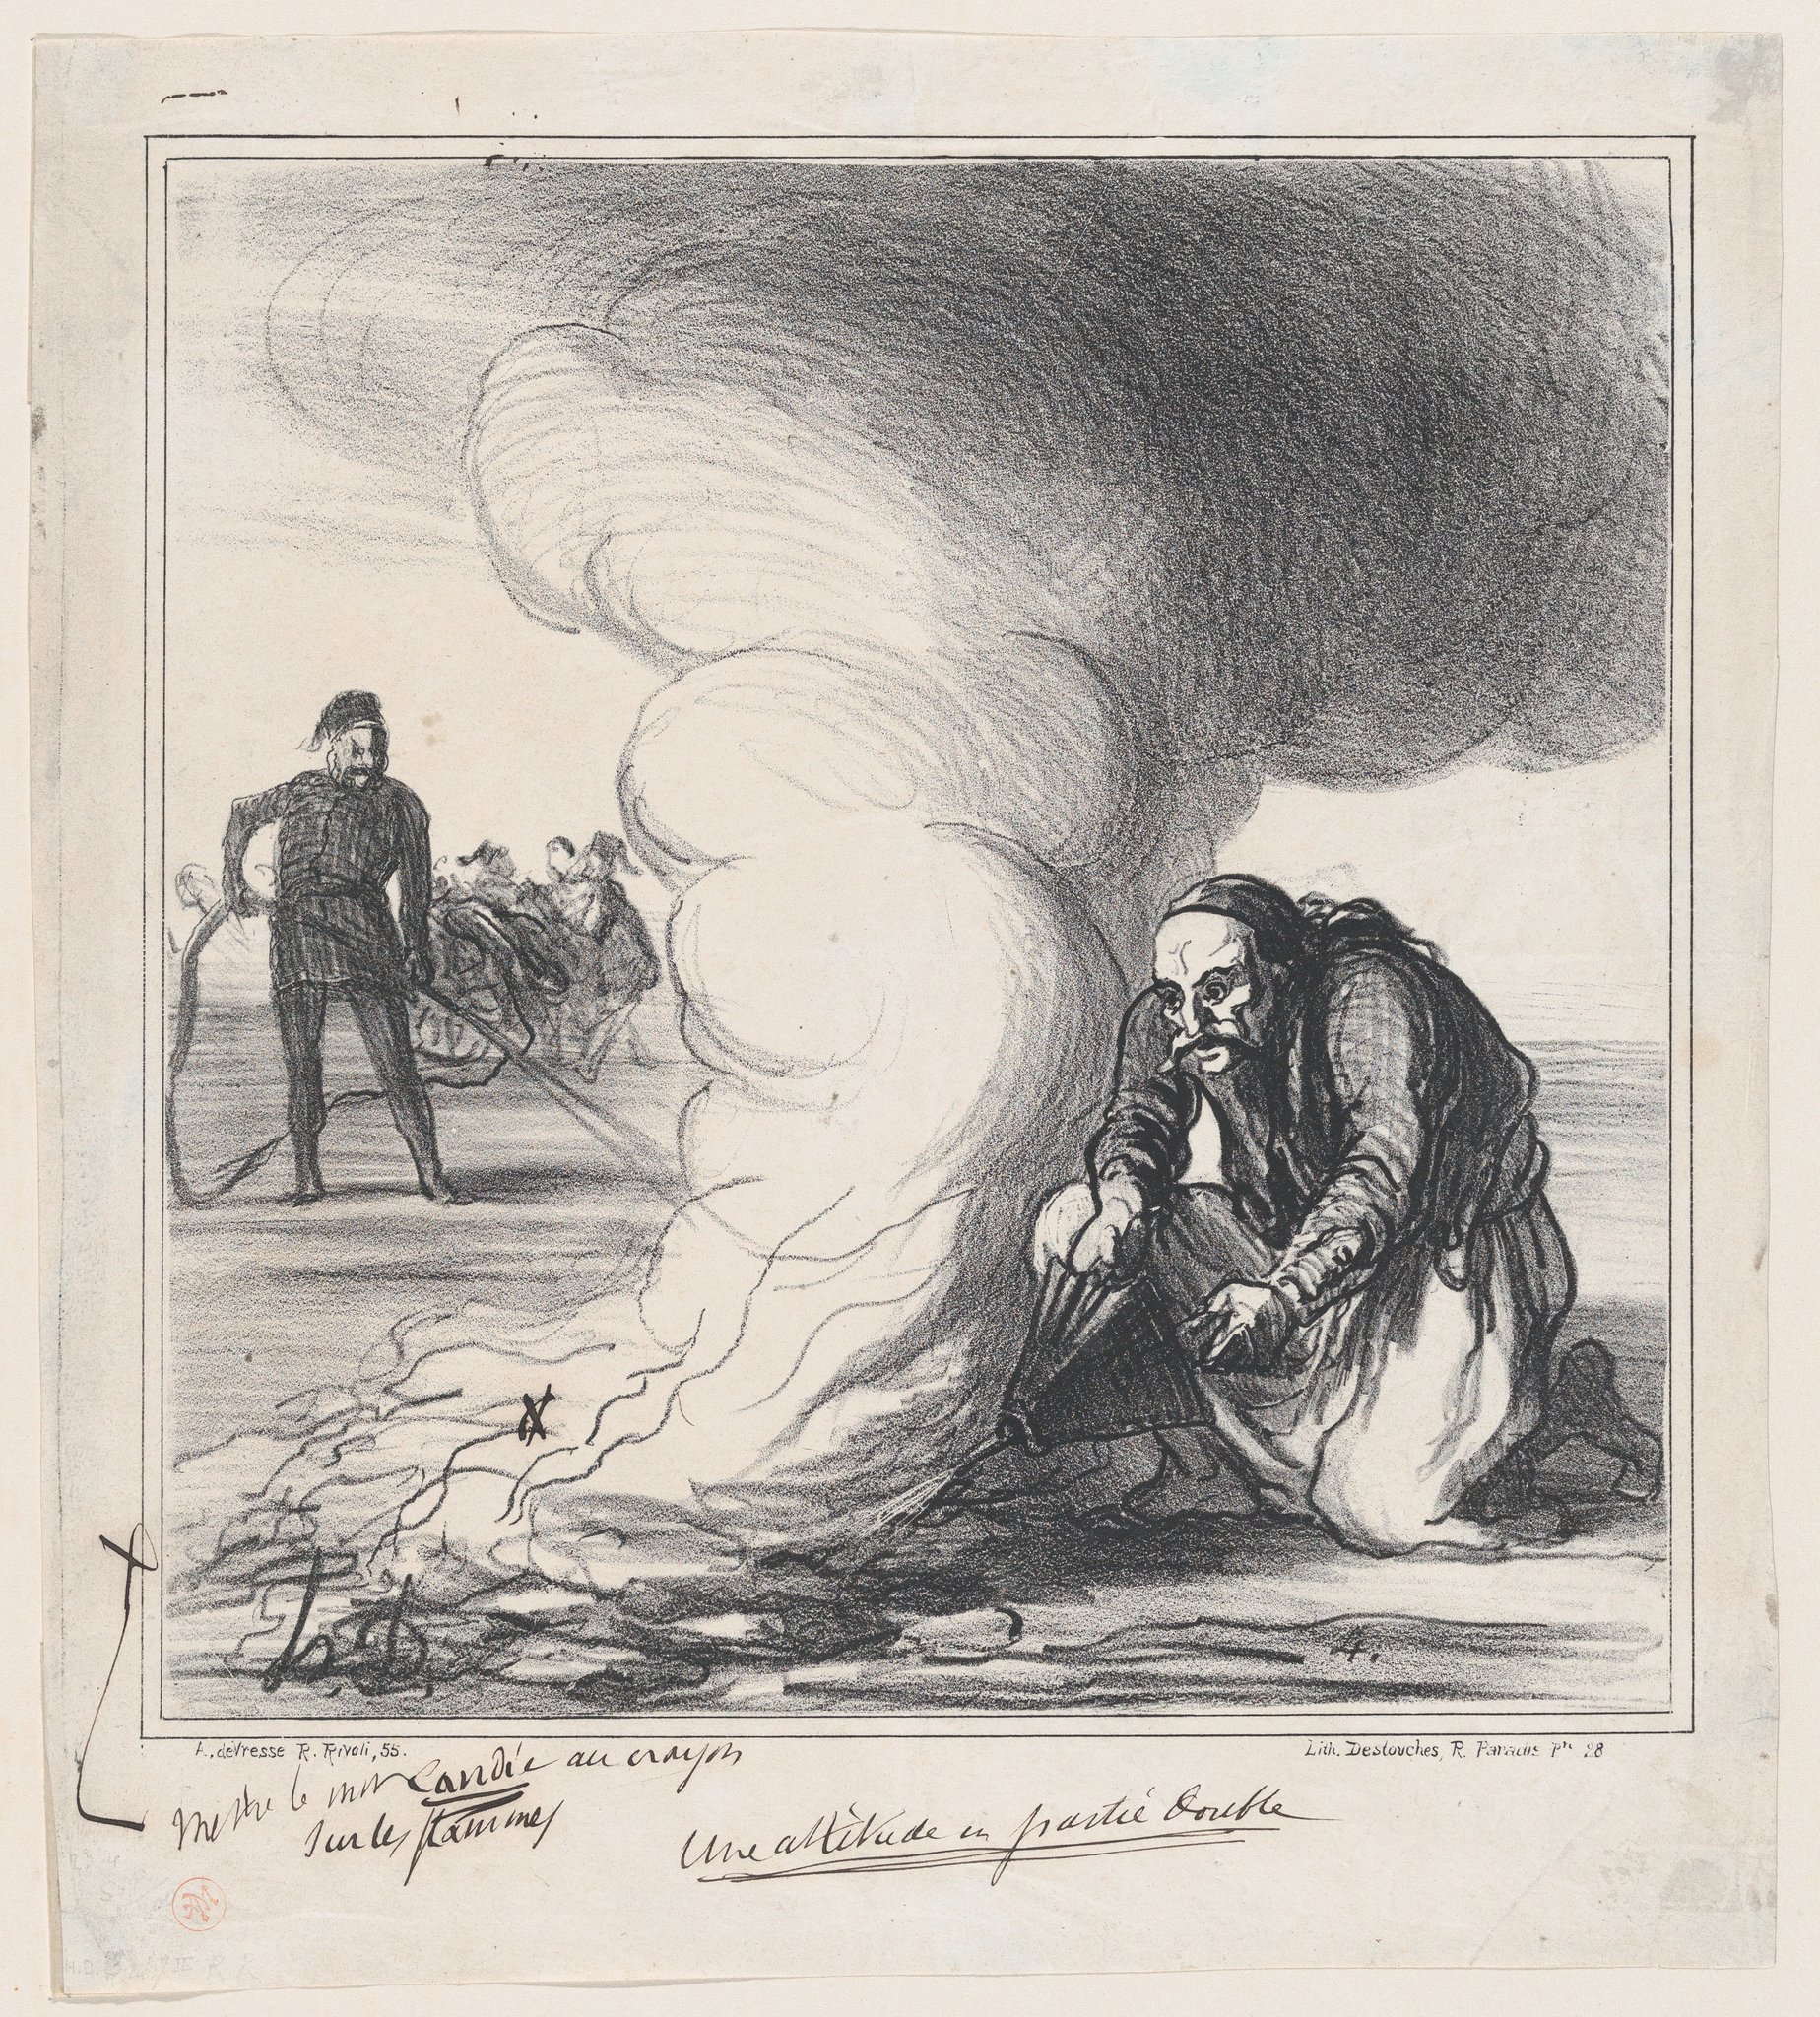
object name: print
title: A treacherous attitude, from 'News of the day,' published in "Le Charivari"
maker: honoré daumier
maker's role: artist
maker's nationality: french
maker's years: 1808-1879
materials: ink, paper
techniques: lithograph, pen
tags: men,fire